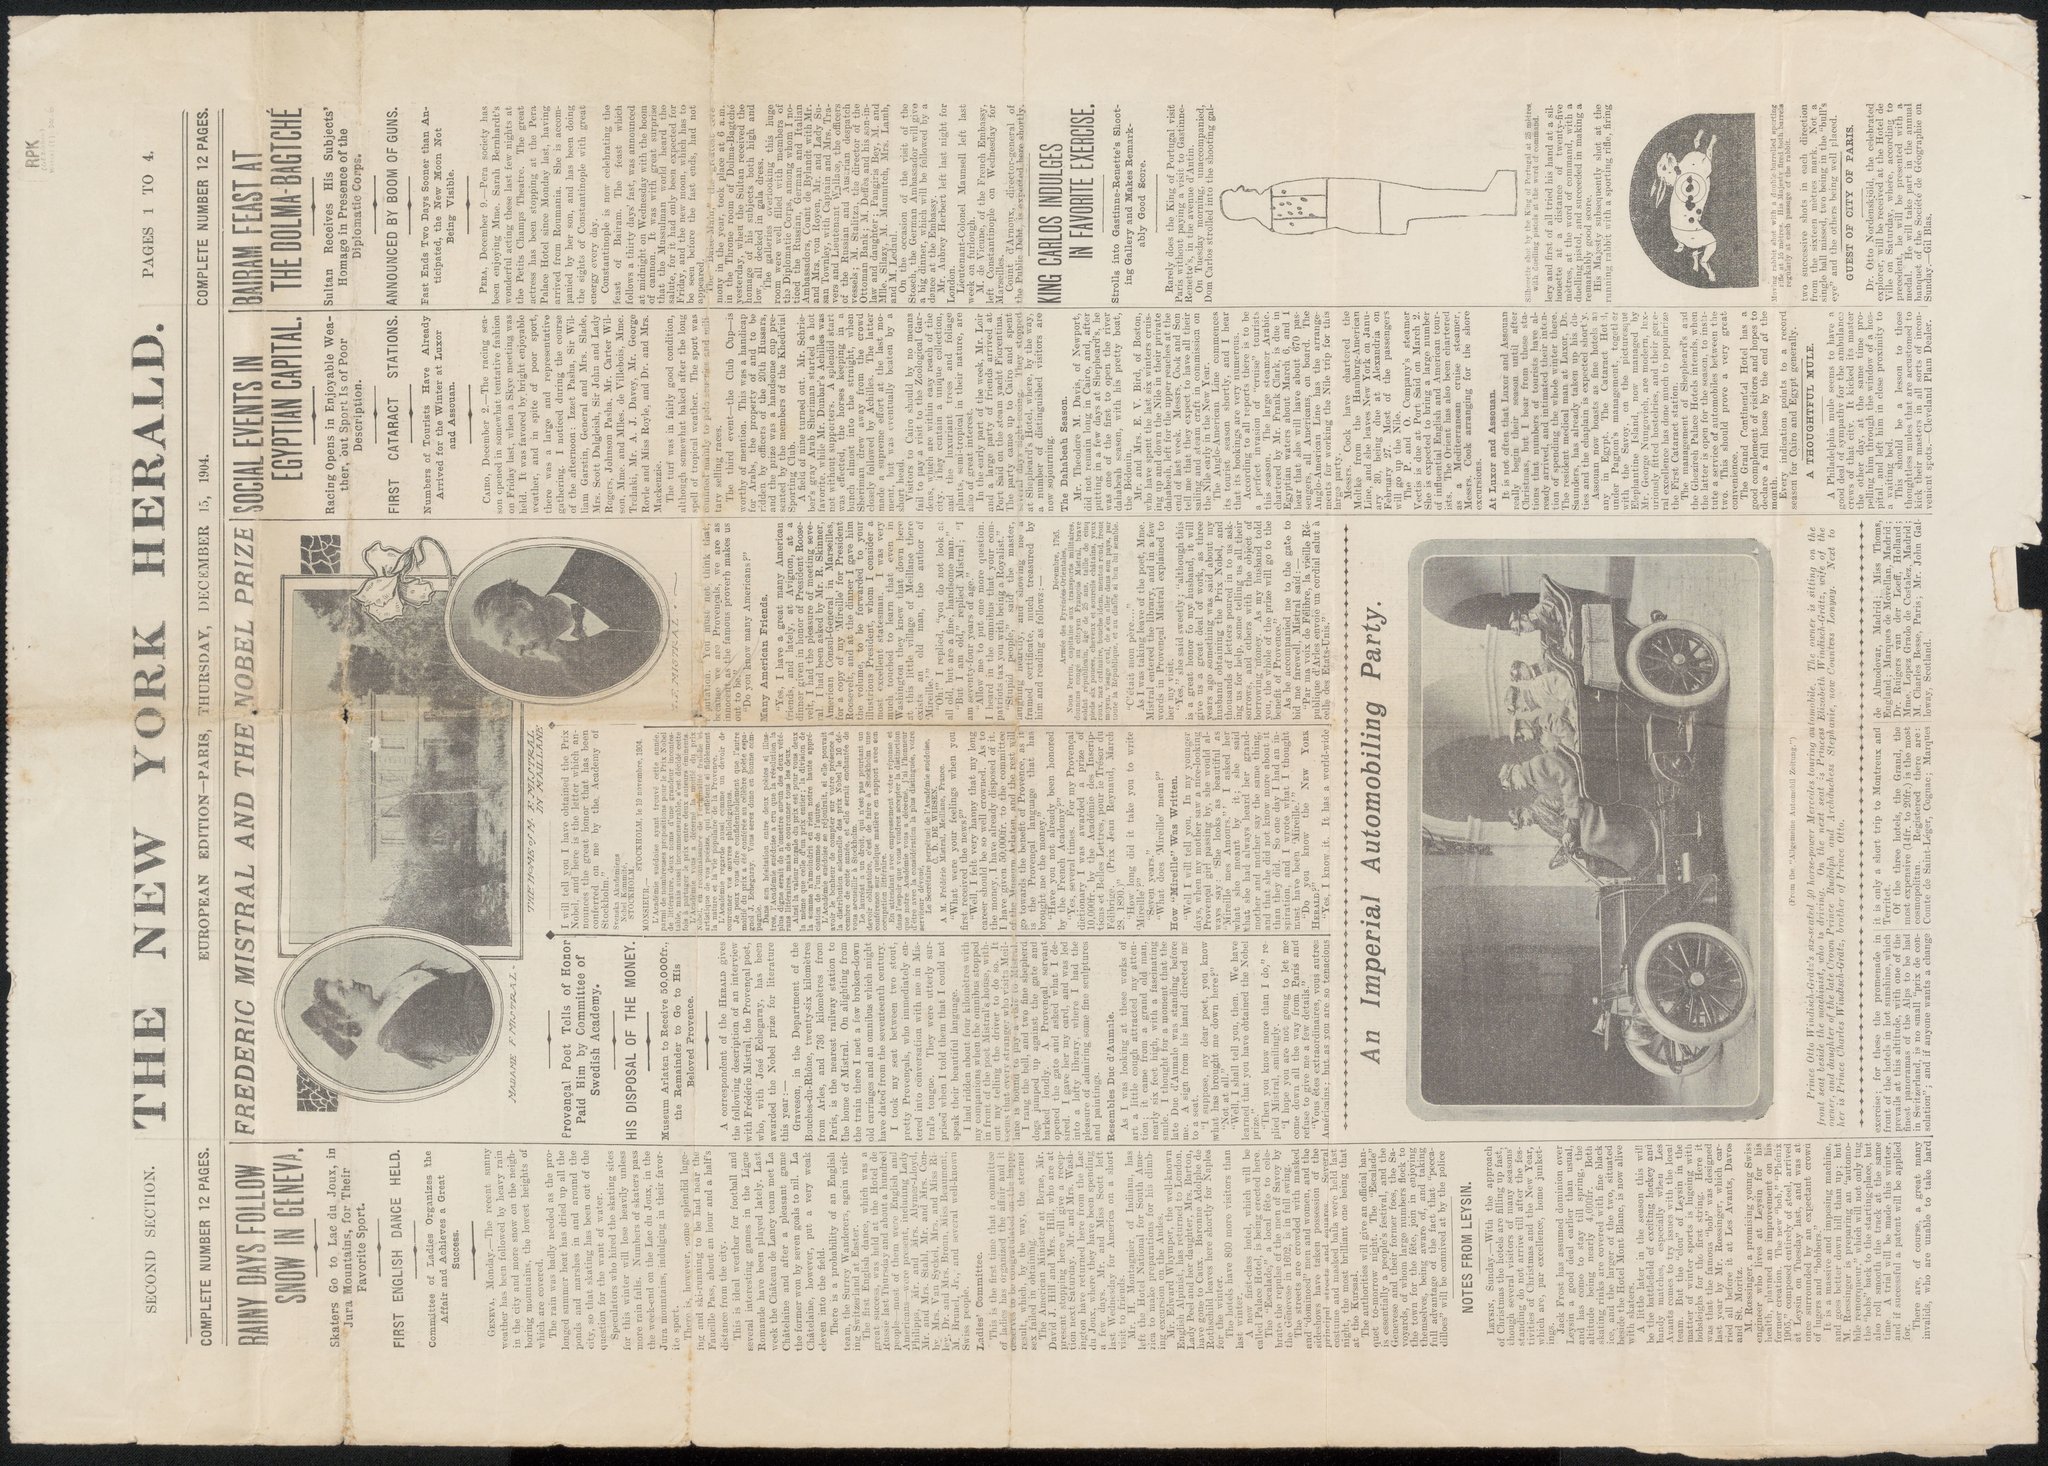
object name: newspaper clipping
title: Krantenknipsel uit archief Philip Zilcken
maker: Anonymous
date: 1904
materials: paper, ink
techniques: printing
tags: frédéric mistral, the hague, painter, draughtsman, philip zilcken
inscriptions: collector's mark: ‘RPK’